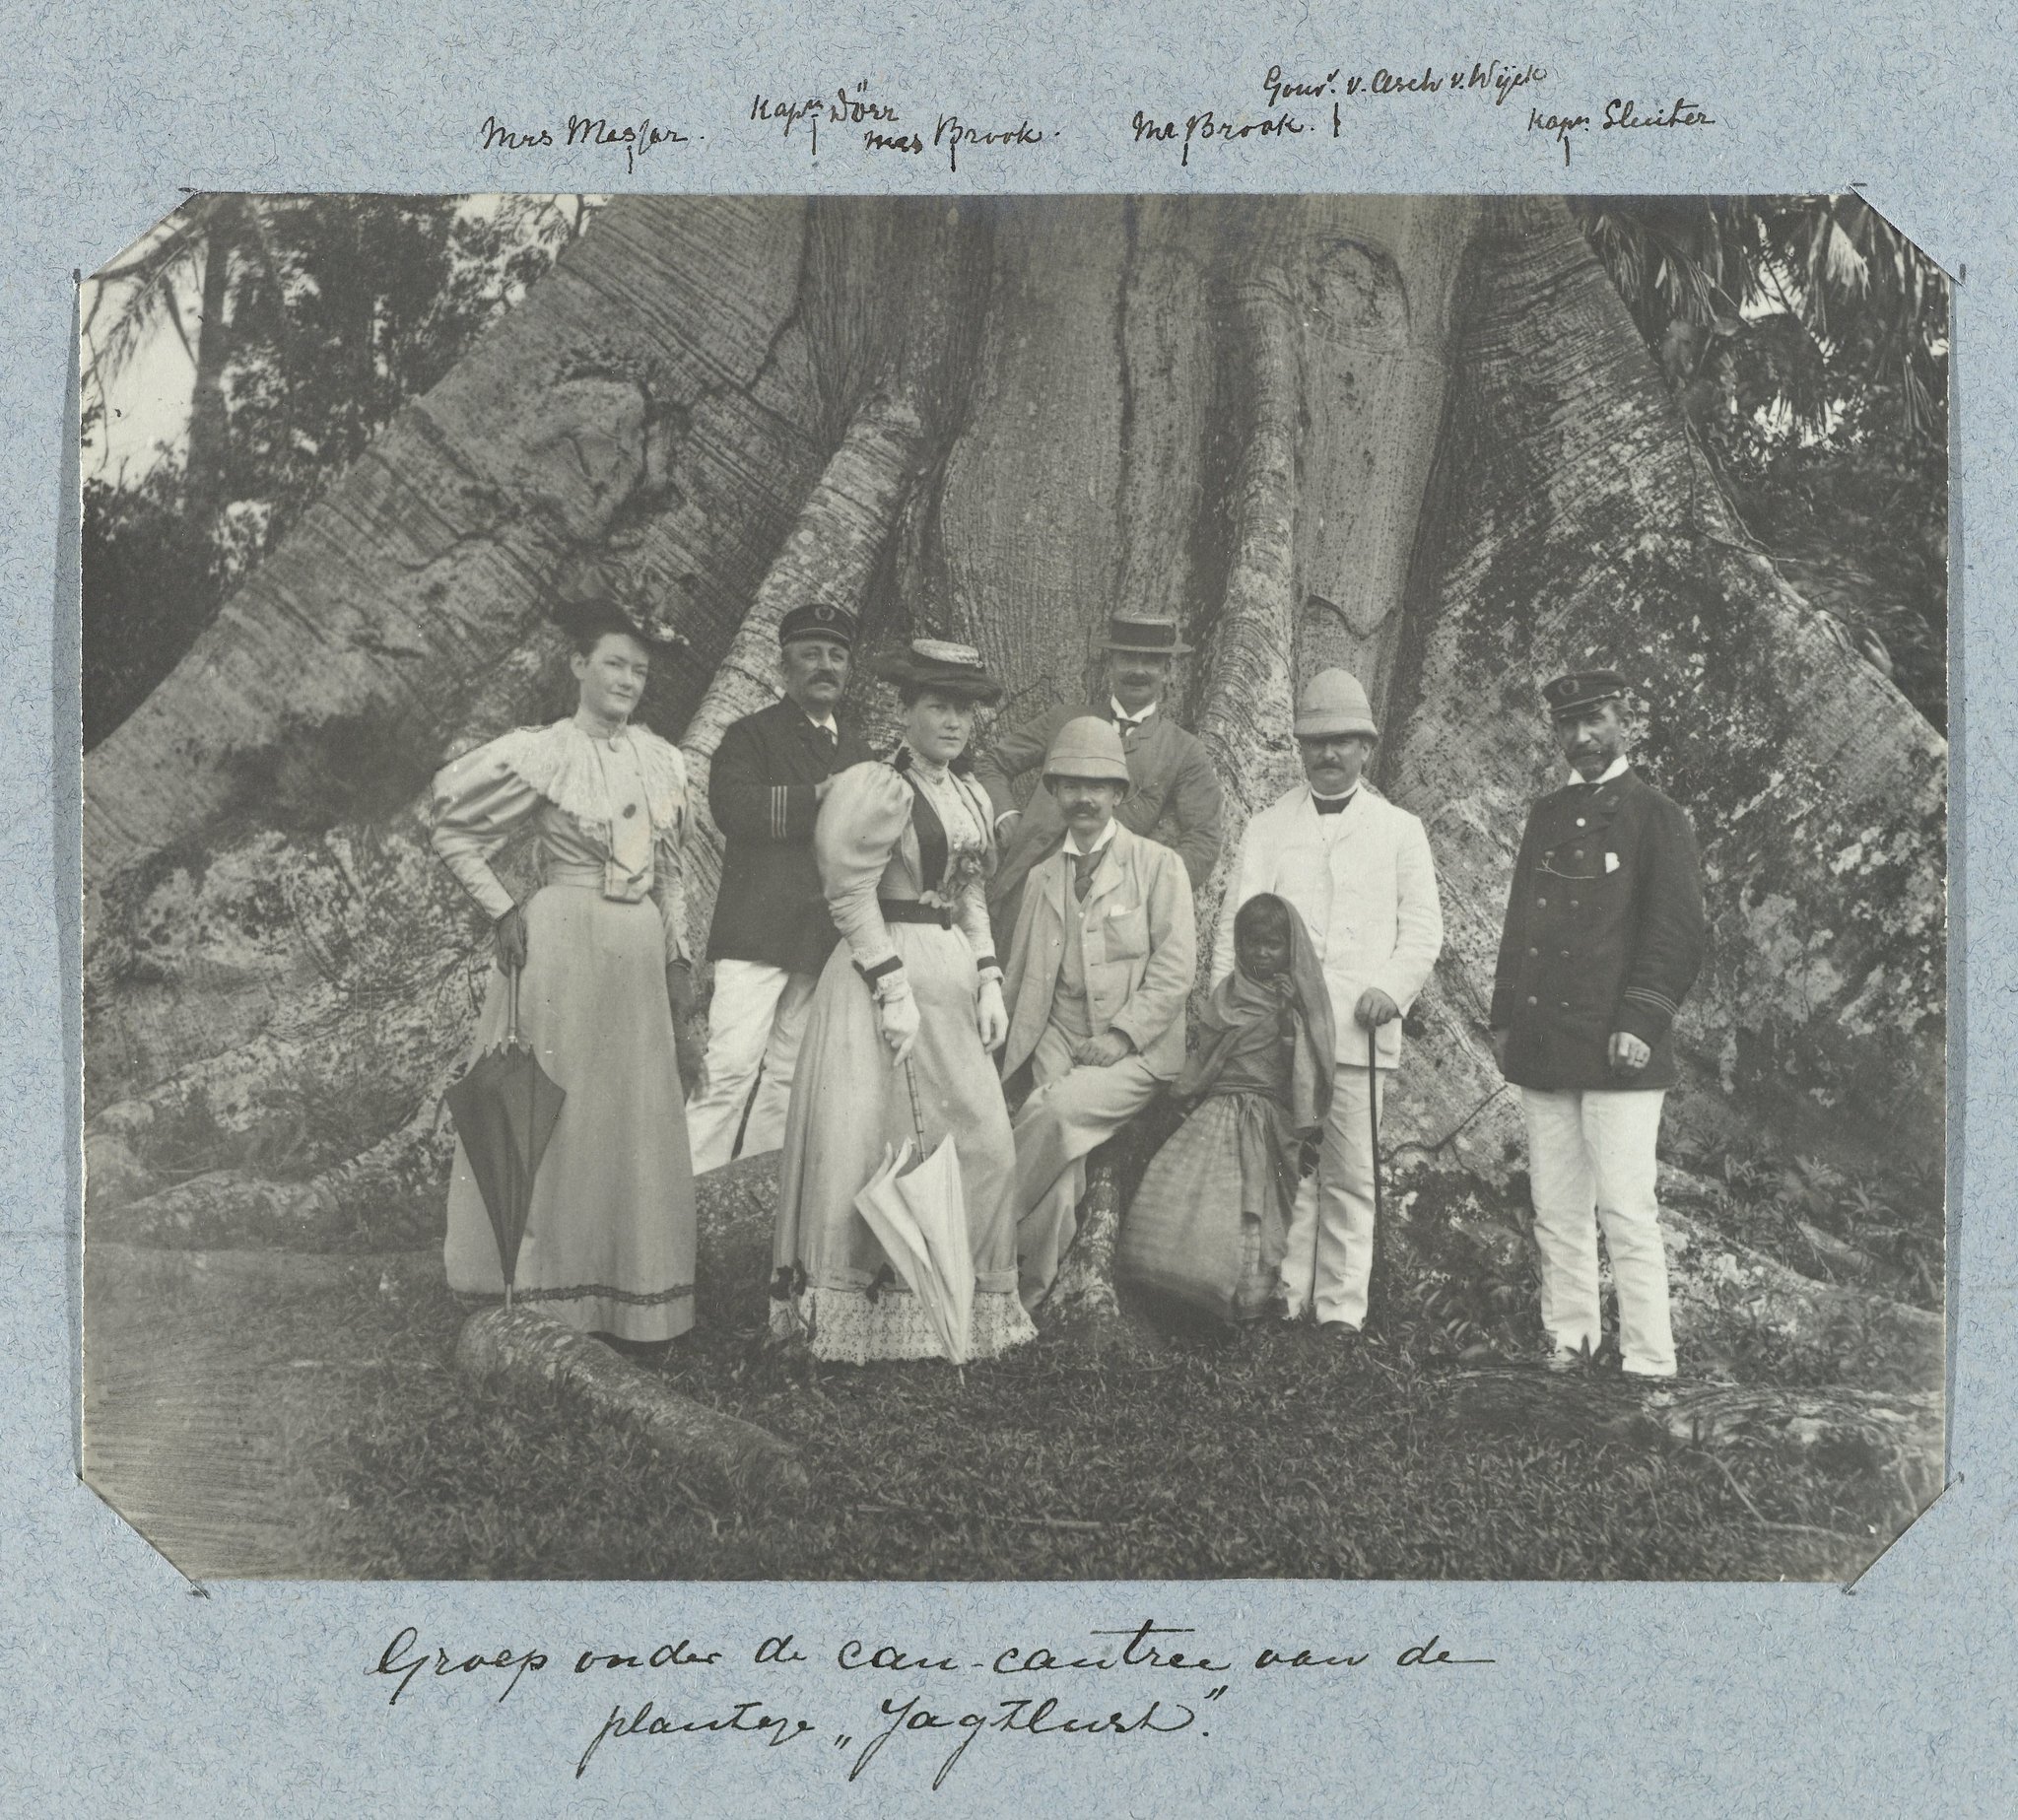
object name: photograph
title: Governor Asch van Wijck with Company at the Jagtlust Plantation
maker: théodore van lelyveld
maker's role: painter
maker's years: 1867-1954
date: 1895-1898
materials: photographic support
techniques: gelatin silver print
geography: suriname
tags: utrecht, the hague, painter, théodore van lelyveld, outing, pleasure trip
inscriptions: inscription: ‘Groep onder de can-cantree van de plantage "Jagtlust" / Mrs Maszar / Kapt. Dörr / Mrs Brook / Mr Brook / Gouv. v. Asch v. Wijck / Kapt. Sluiter.’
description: The photographer Van Lelyveld takes this group portrait on the Jagtlust Plantation near an imposing kapok tree (kankantrie). In his album he notes all the sitters’ names except that of the Hindustani girl. Was she spontaneously invited to be in the photograph? Would her mother have given her permission? Many women die during childbirth from exhaustion and poor sanitary conditions; perhaps the girl is an orphan.